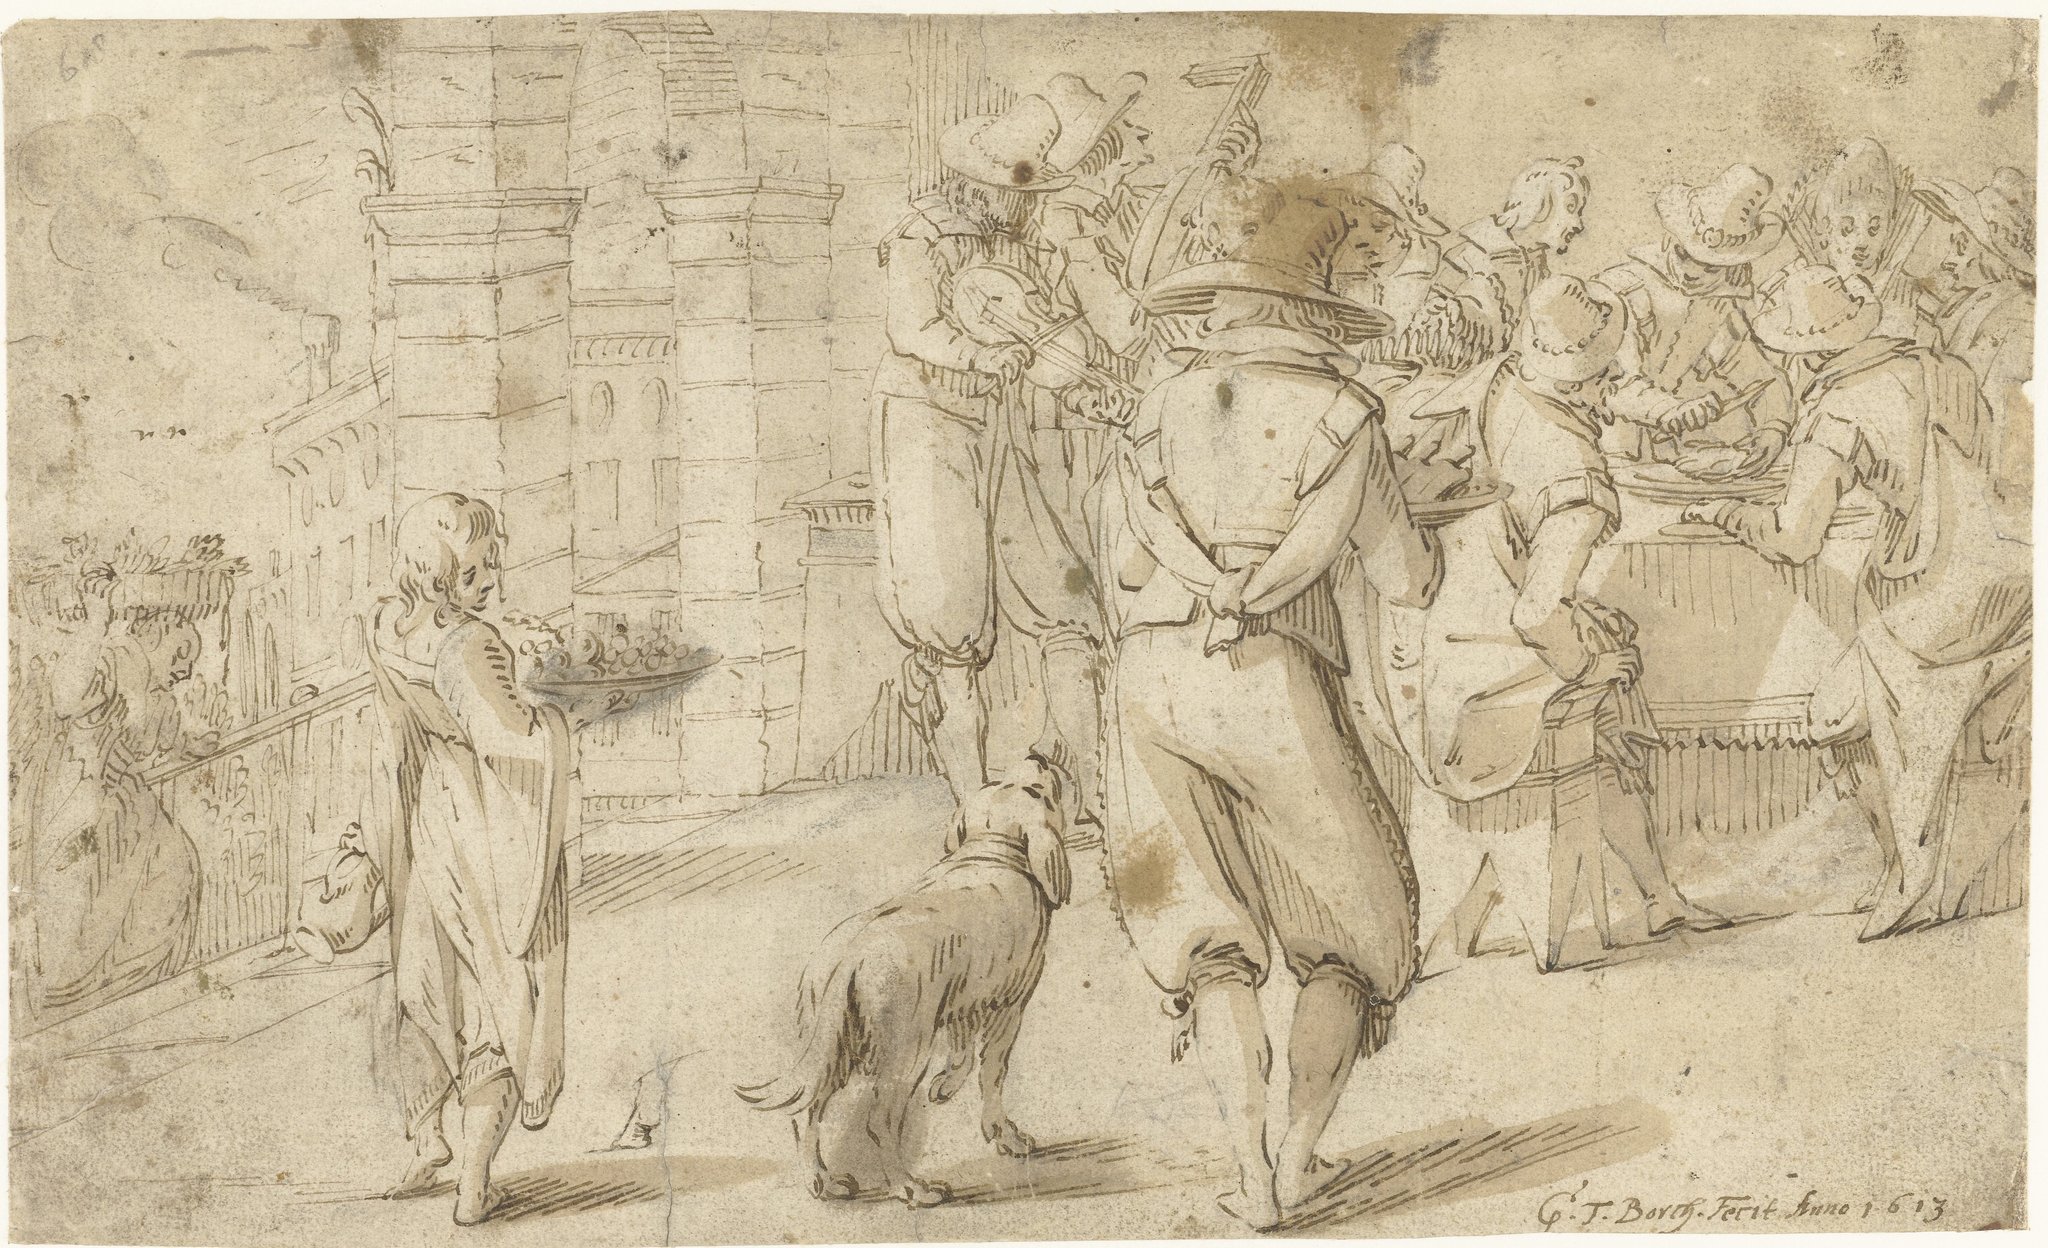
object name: drawing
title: Gezelschap bij een banket op een Italiaans terras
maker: gerard ter borch (i)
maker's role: draughtsman, print maker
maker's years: 1584-1662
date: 1613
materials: chalk, ink, paper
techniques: brush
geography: zwolle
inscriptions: signature and date: ‘G.T.Borch.Fecit.Anno 1613’